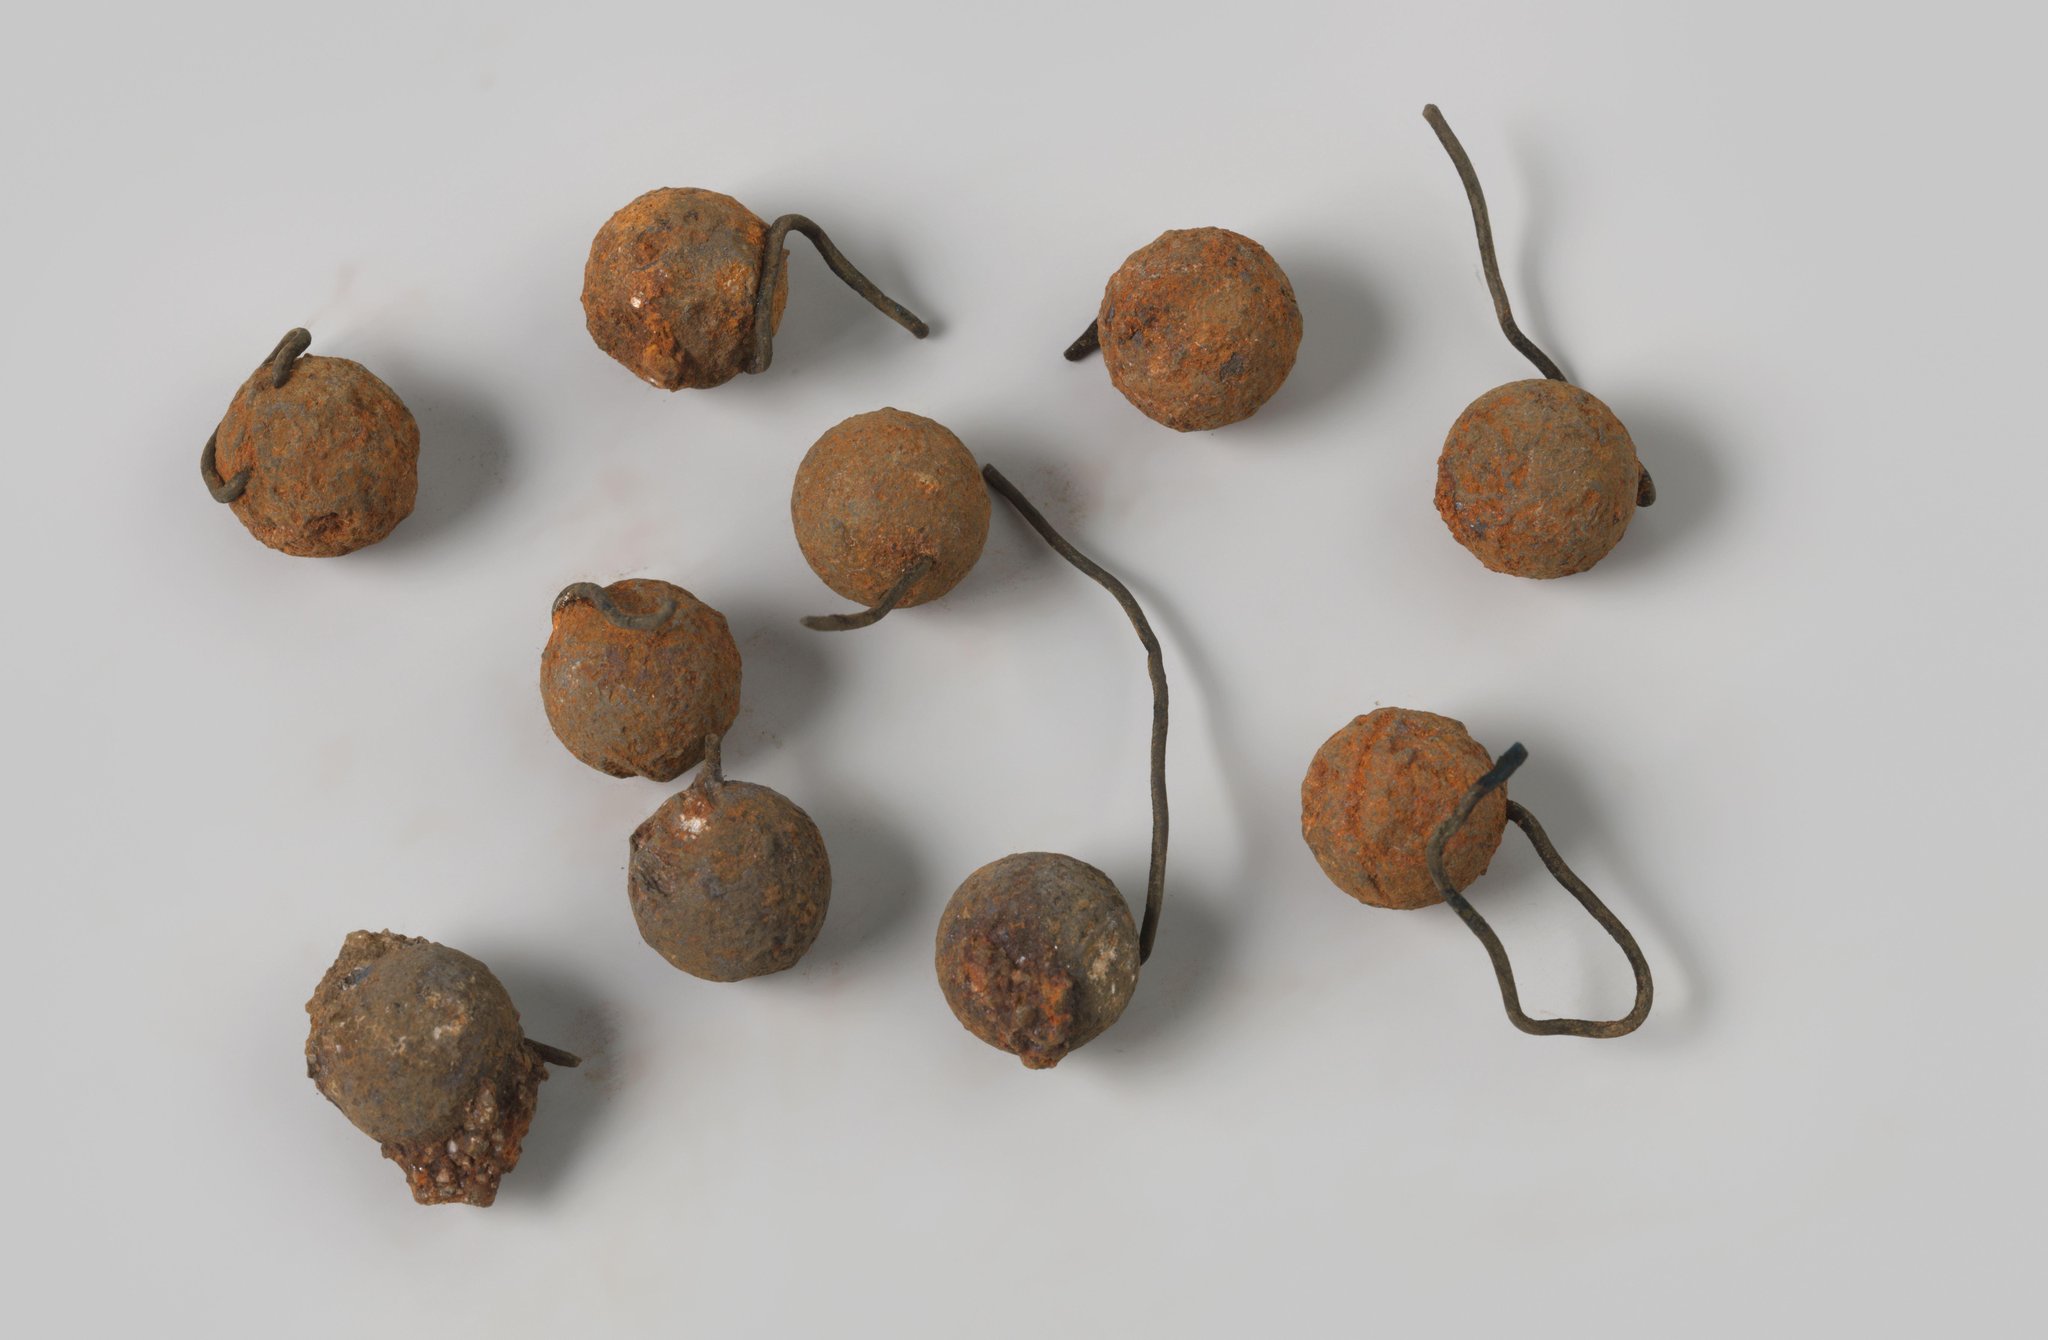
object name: chain shot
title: Kettingkogels uit het wrak van de Oost-Indiëvaarder Hollandia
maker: Anonymous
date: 1700-1743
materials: lead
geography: netherlands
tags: verenigde oostindische compagnie, hollandia (schip), annet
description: Shot, springshot; fragment single balls with wire fragment, id. NG 1980-27H3168.